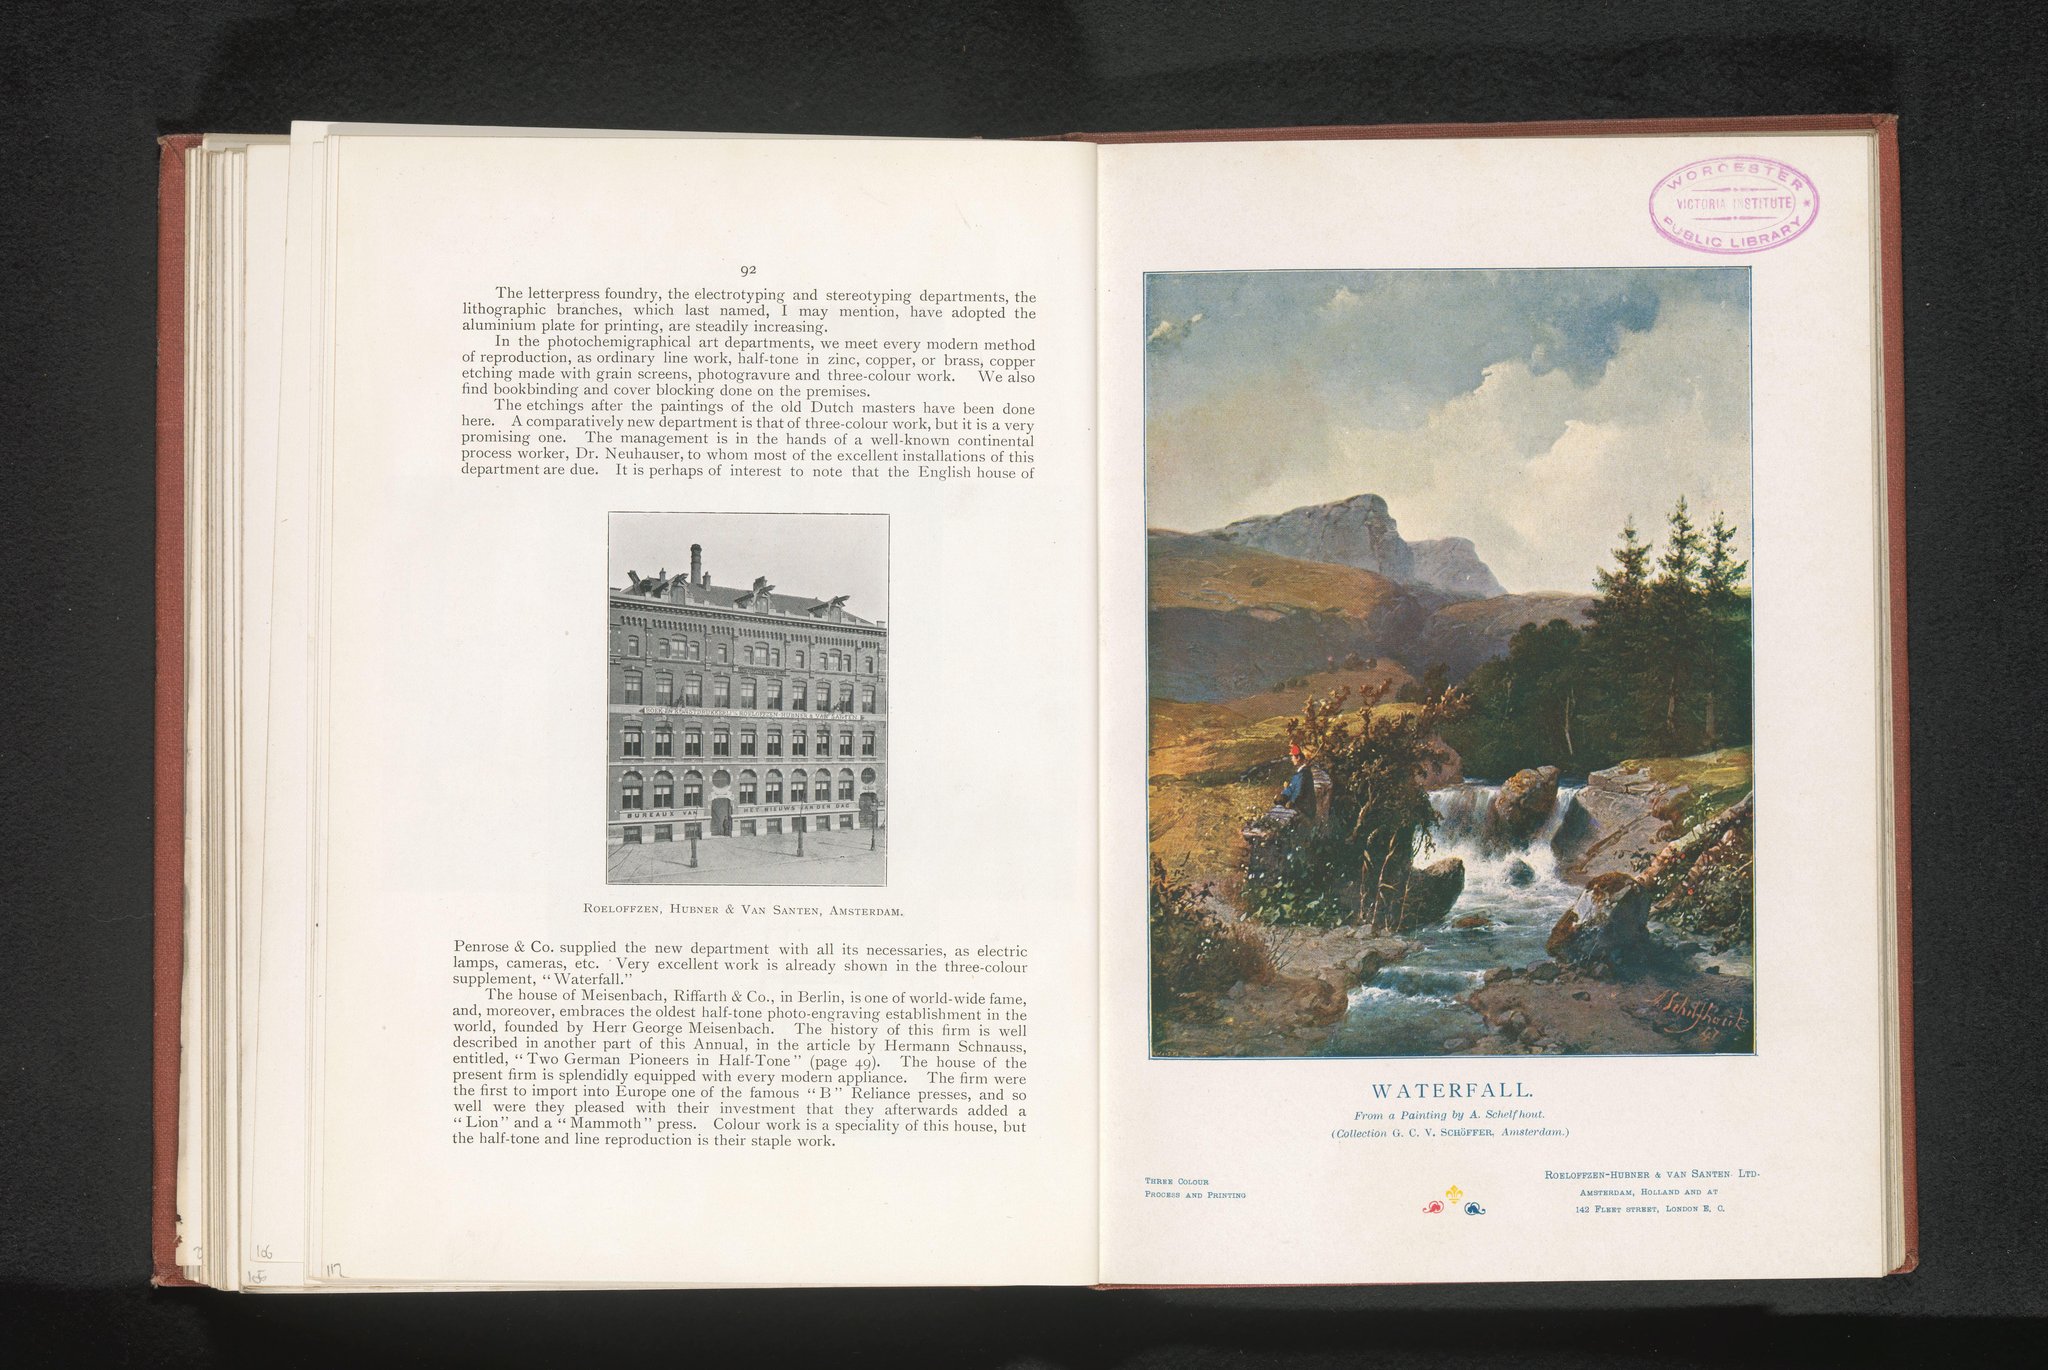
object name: photomechanical print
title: Reproductie van een schilderij van een landschap met waterval door Andreas Schelfhout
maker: andreas schelfhout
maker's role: draughtsman, painter, print maker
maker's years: 1787-1870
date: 1895-1900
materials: paper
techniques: three-color autotype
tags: waterfall (+ landscape with figures, staffage)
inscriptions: collector's mark: ‘Worcester Public Library/ Victoria Institute’, inscription: ‘From a Painting by A. Schelfhout./ (Collection G.C.V. Schöffer, Amsterdam.)’